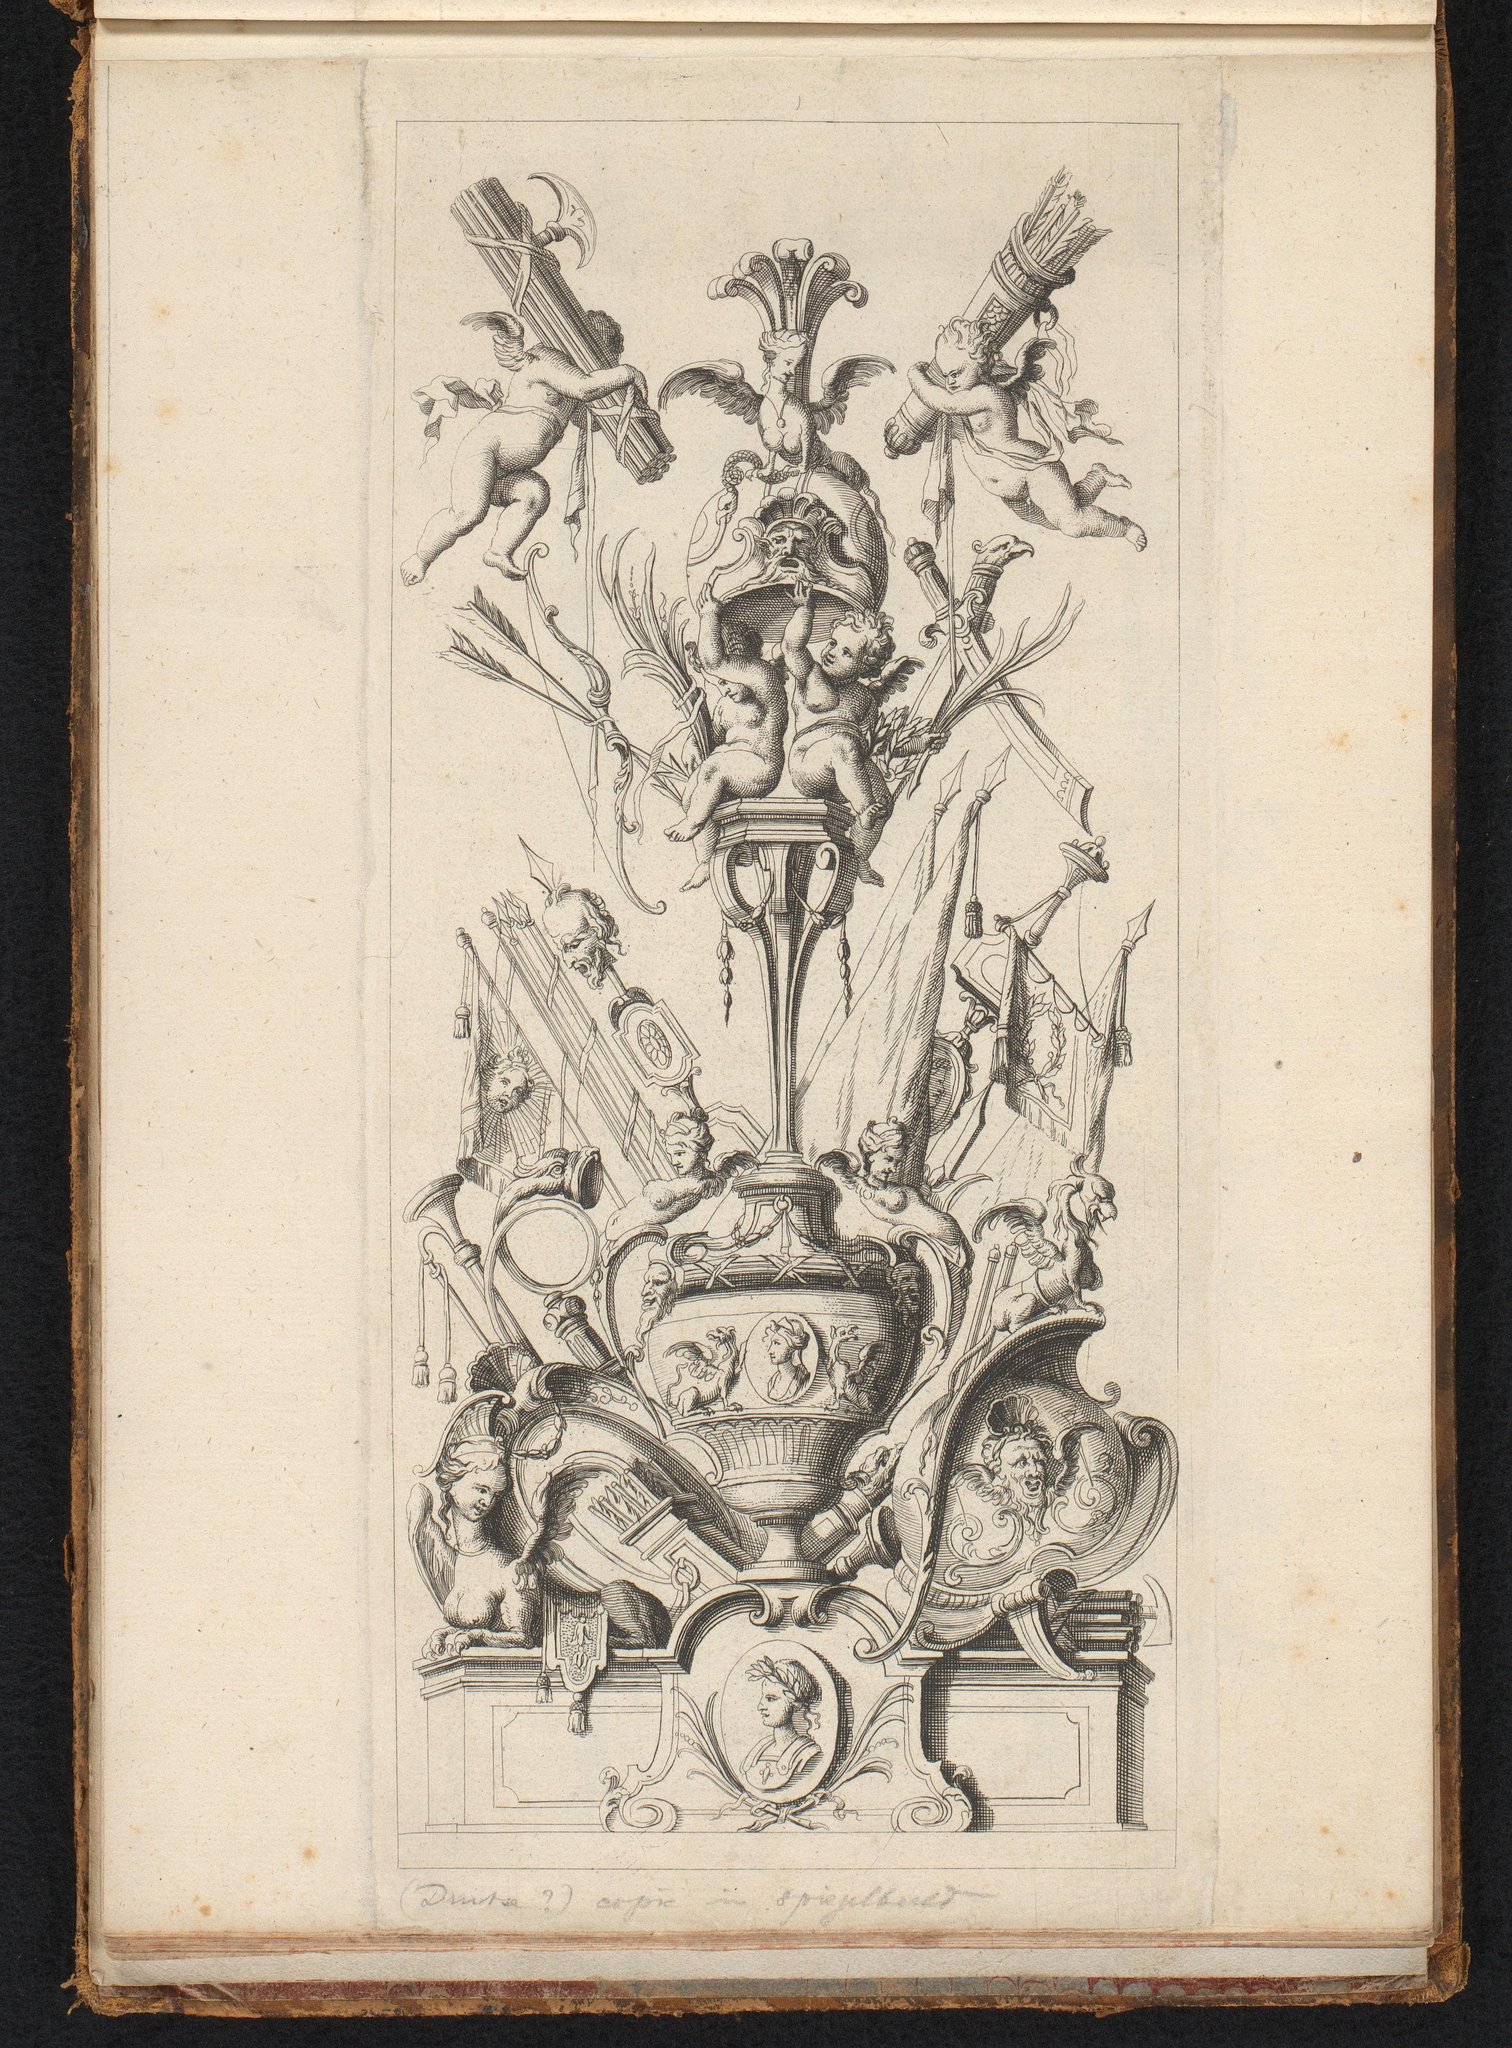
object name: album leaf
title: Trofee met vaas en putti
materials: paper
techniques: etching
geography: paris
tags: 'tropaion', i.e. decorative ornament ~ weapons, weapons, cupids: 'amores', 'amoretti', 'putti'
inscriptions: annotation: ‘(Duitse?) copie in spiegelbeeld’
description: Kopie in spiegelbeeld naar een ontwerp van Jean Bernard Honoré Turreau. Volgens een annotatie in potlood gaat het om een Duitse kunstenaar.